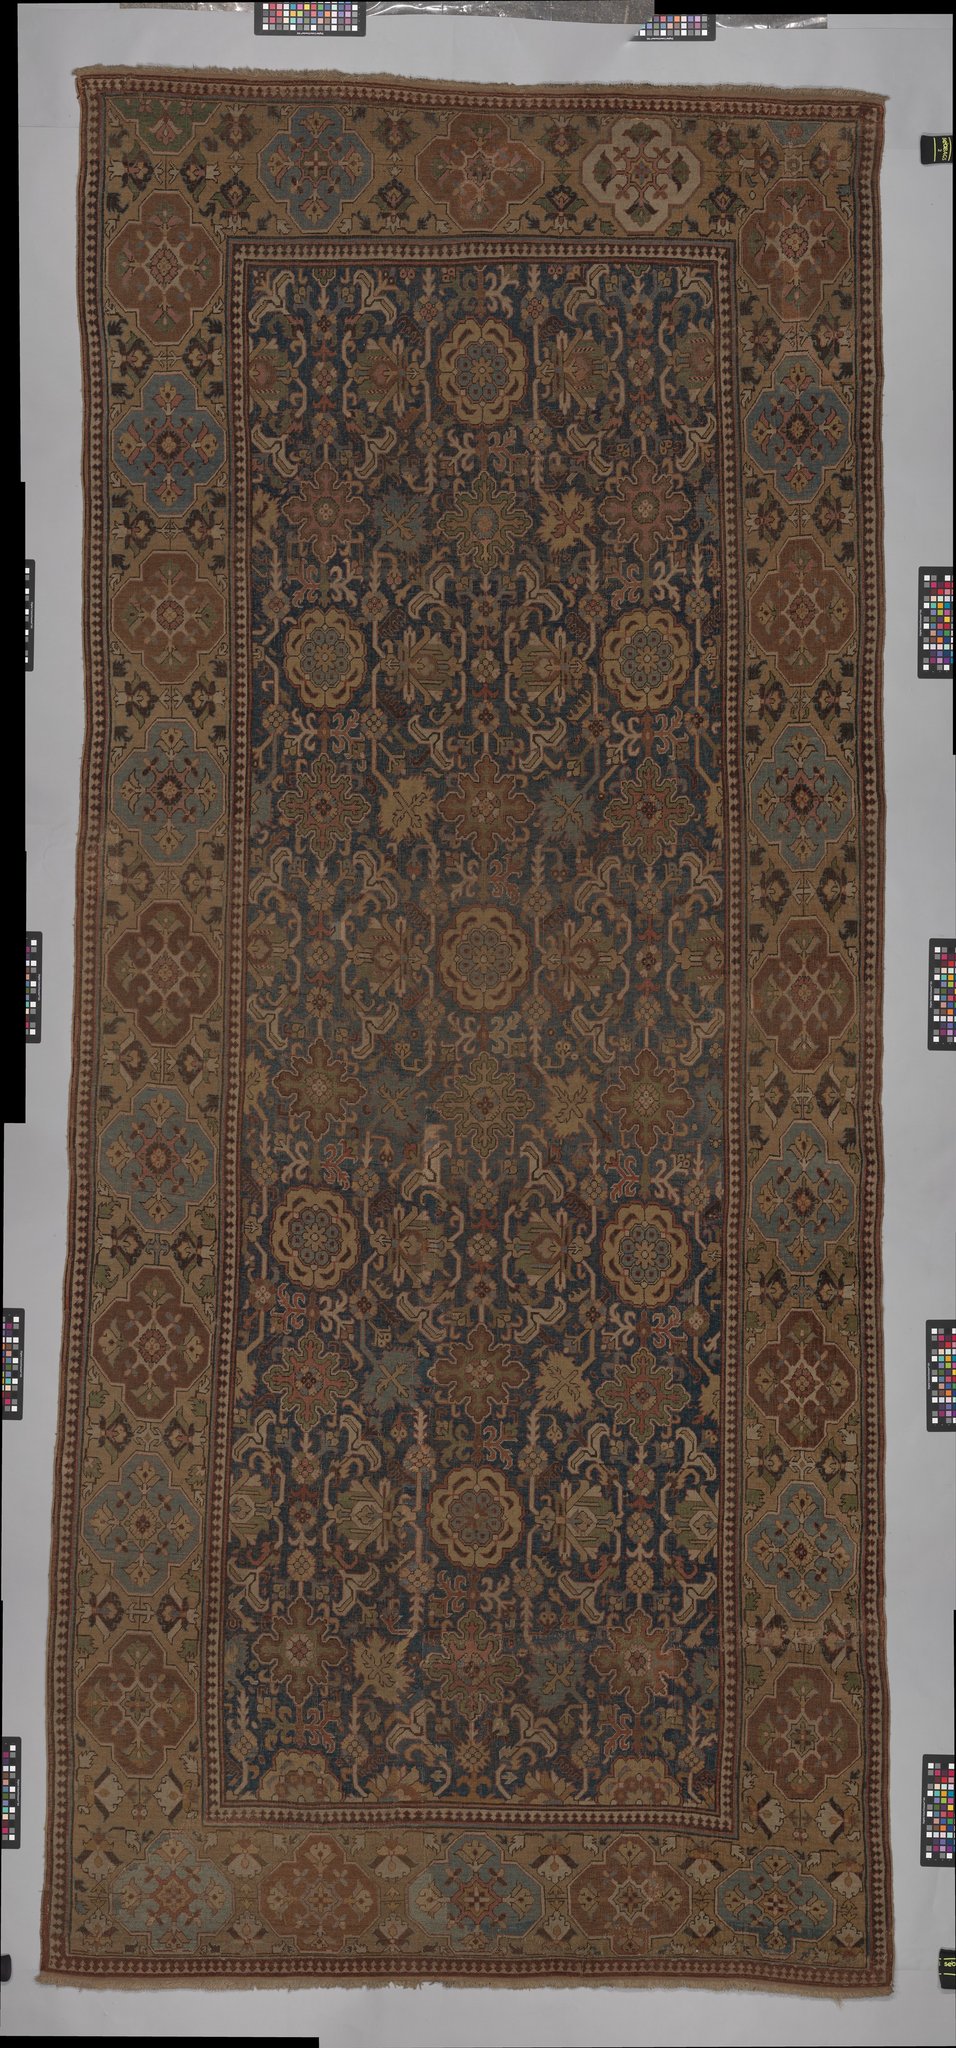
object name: carpet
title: Harshang Carpet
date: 1701-1800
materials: wool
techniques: pile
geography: caucasus